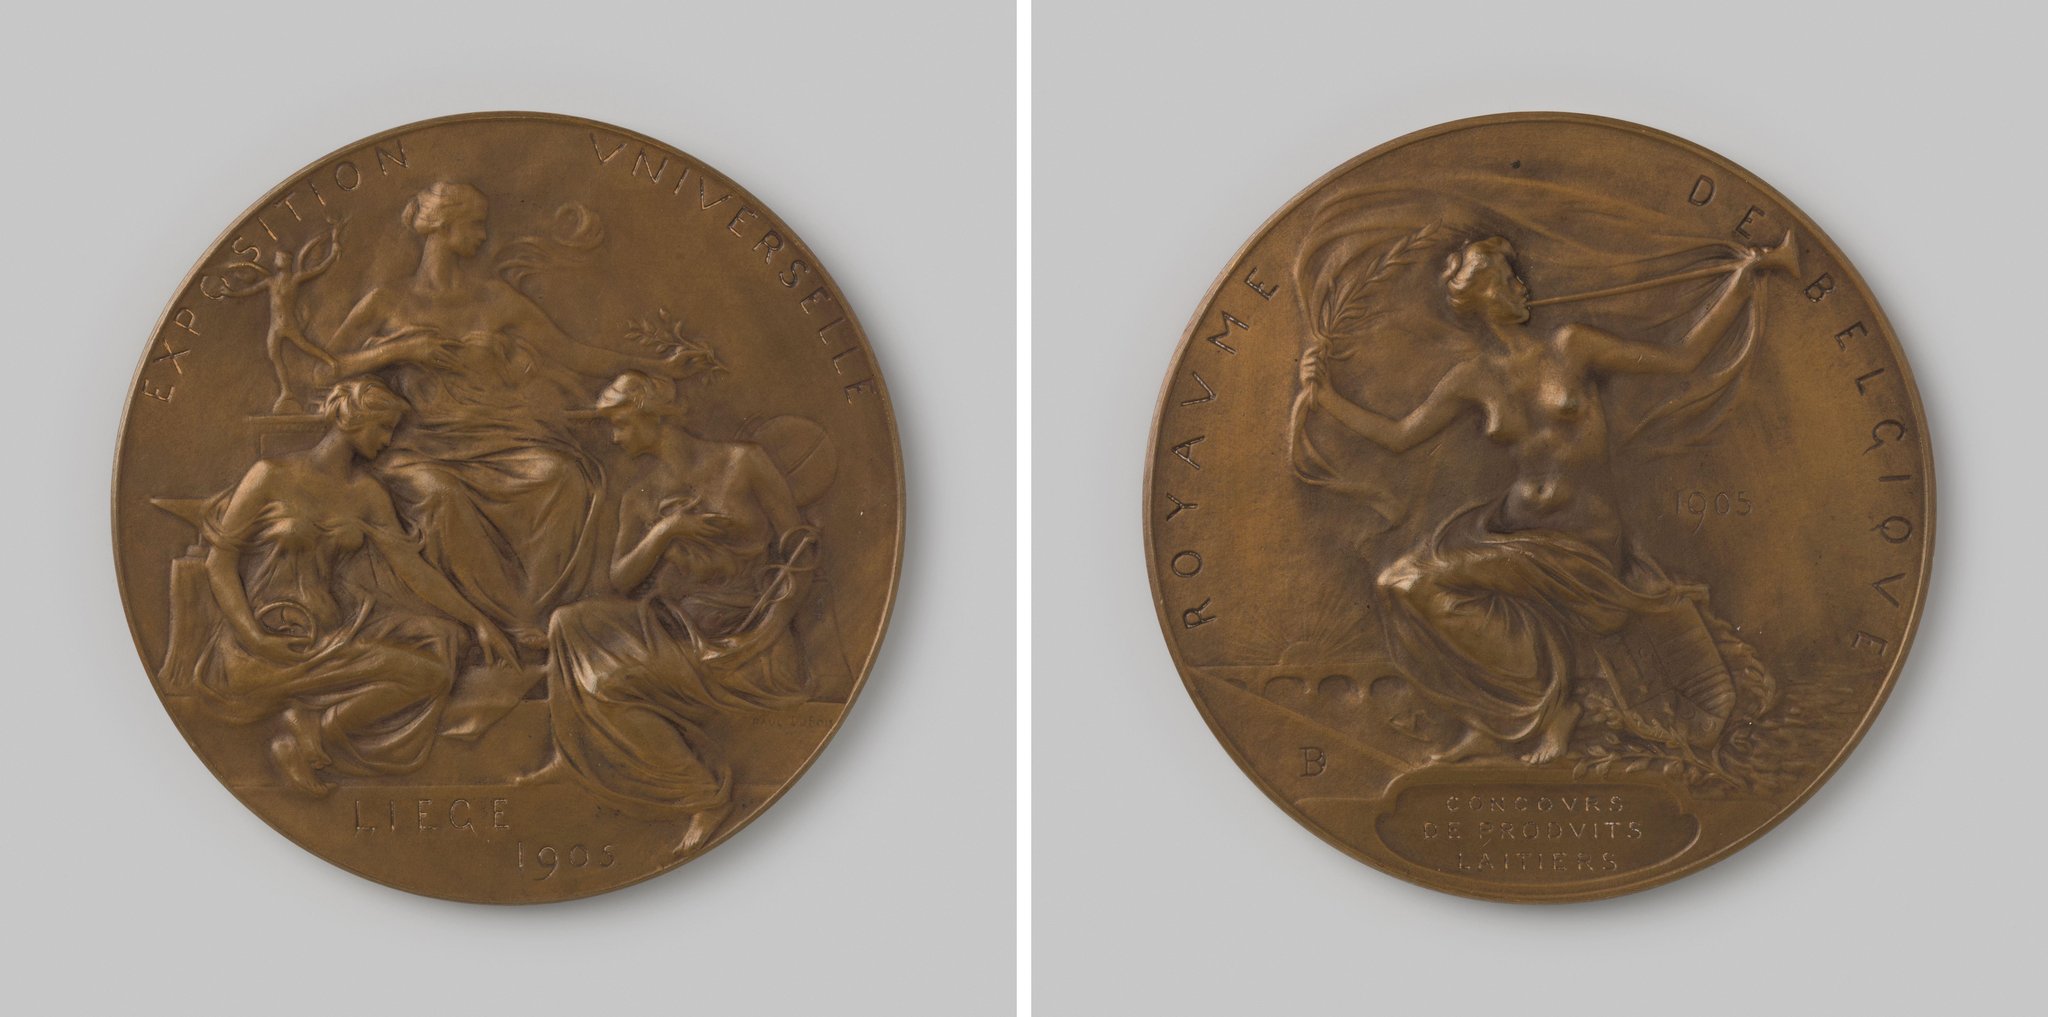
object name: history medal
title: Wereldtentoonstelling te Luik 1905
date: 1905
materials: bronze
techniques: striking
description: Bronzen penning, op de voorzijde drie zittende vrouwen met symbolen van handel, nijverheid, wetenschap en kunst, met omschrift en afsnedetekst, op de keerzijde een Faam met trompet en palmtak op een wapenschild, in een landschap met brug en opgaande zon, met omschrift en onderaan een cartouche met drie regels tekst.